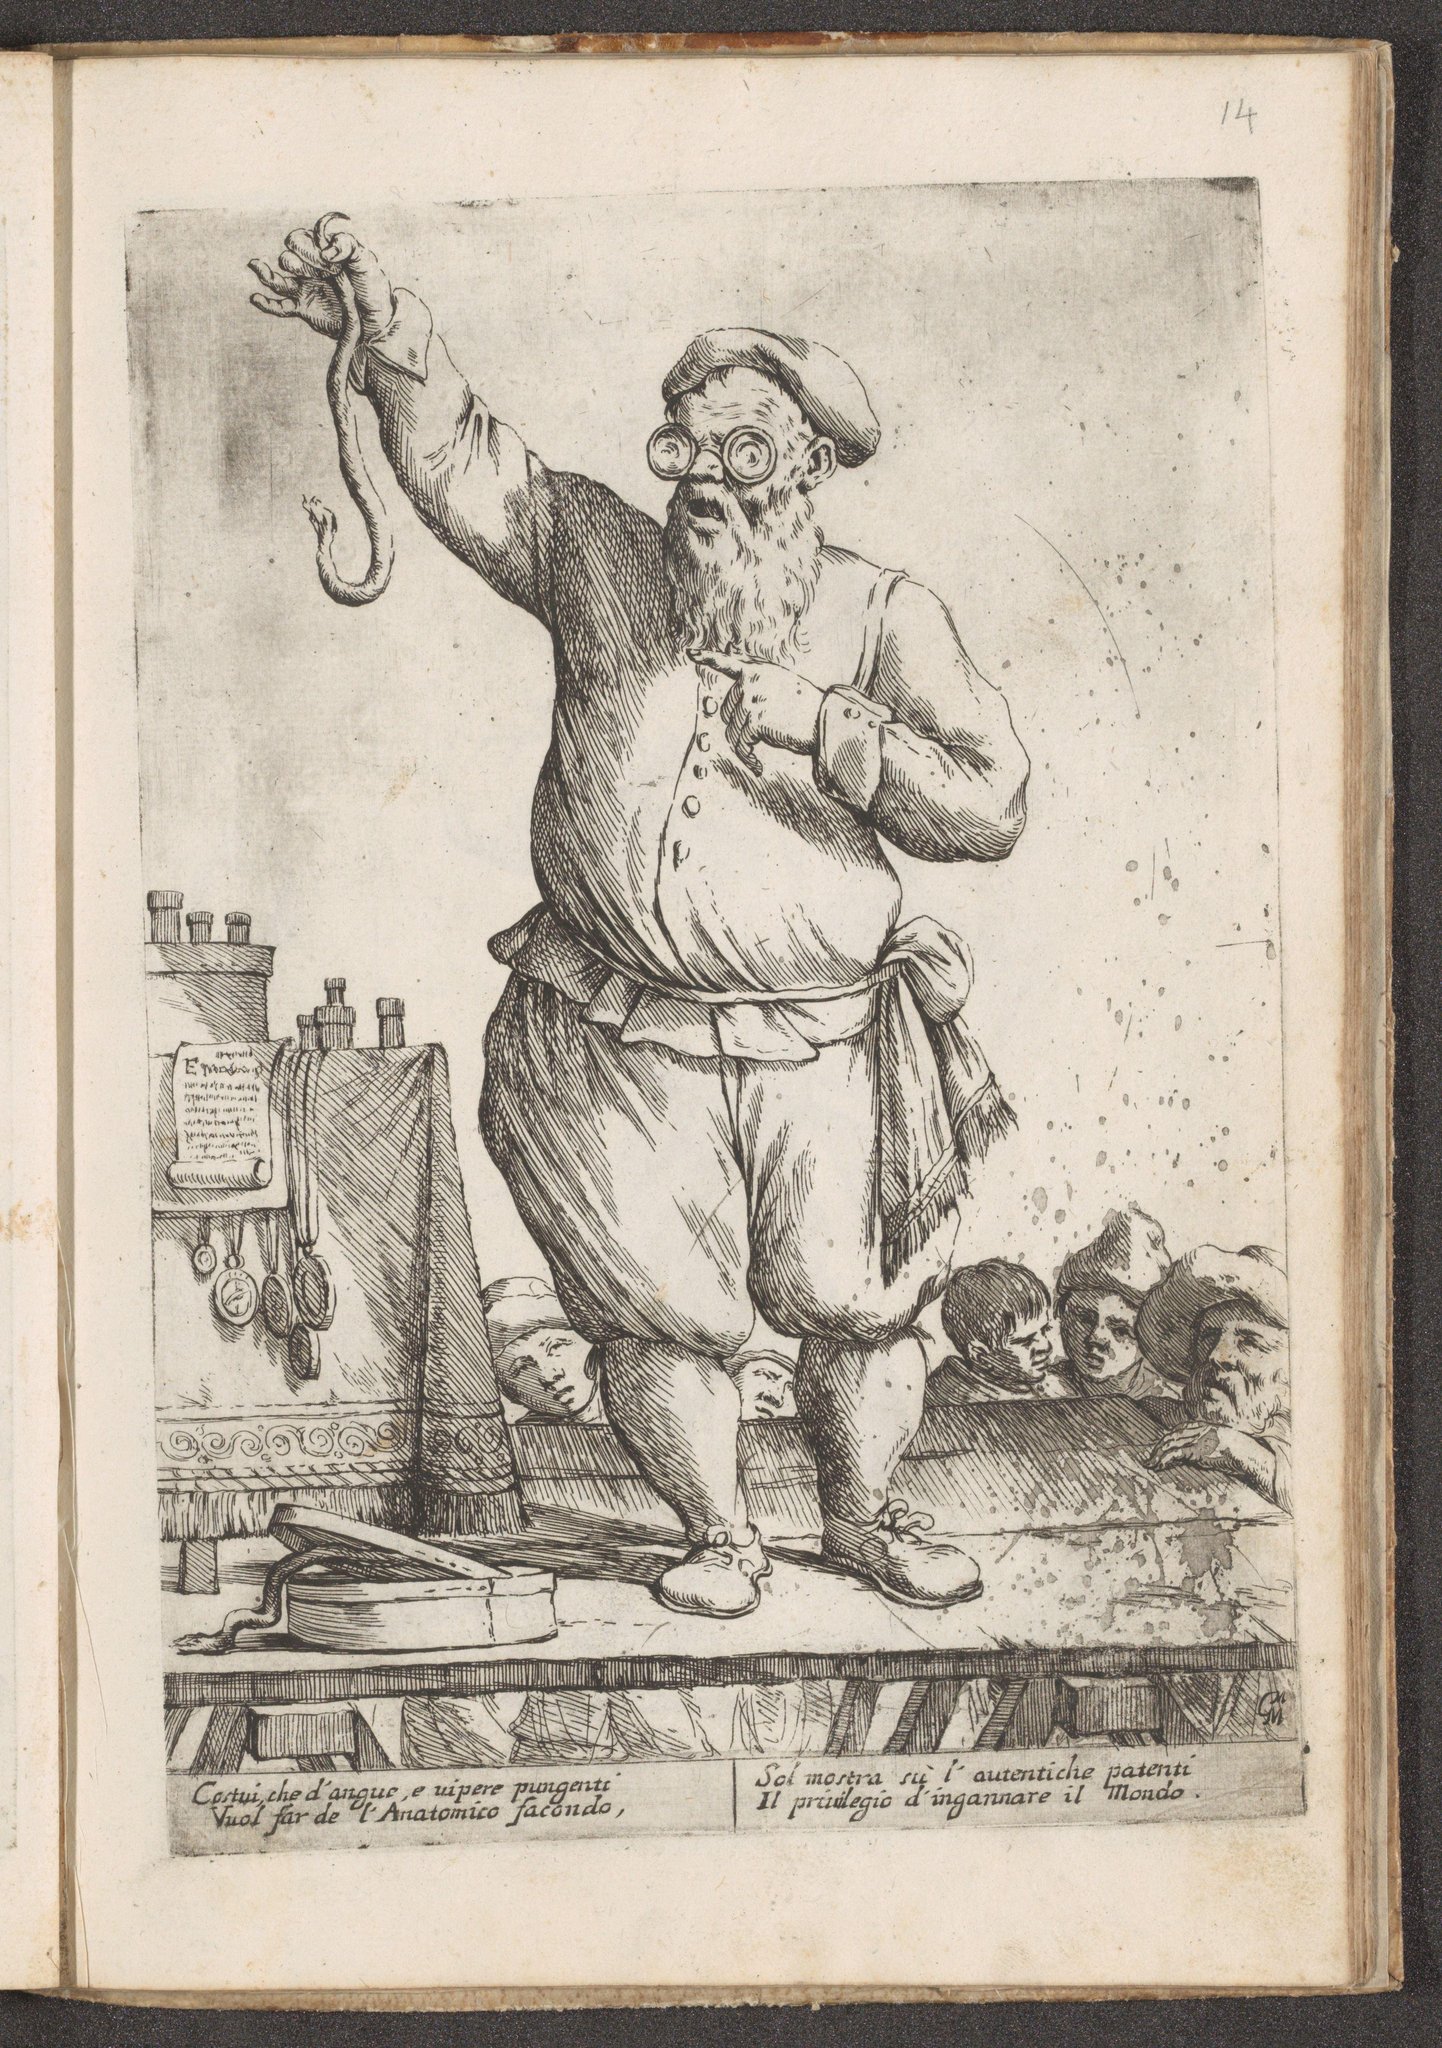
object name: print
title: L'Arti Per Via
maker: giuseppe maria mitelli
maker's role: draughtsman, painter, print maker, publisher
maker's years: 1634-1718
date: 1660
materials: paper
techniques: aquatint, etching, intaglio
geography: bologna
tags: snakes, quack, charlatan, mountebank, 'saltimbanco', street-trader, 'cris de paris', cries of london, etc.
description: Een kwakzalver met een grote bril, staand op een verhoging, met een slang in de hand. Italiaans vers in ondermarge. De prent maakt deel uit van een album.